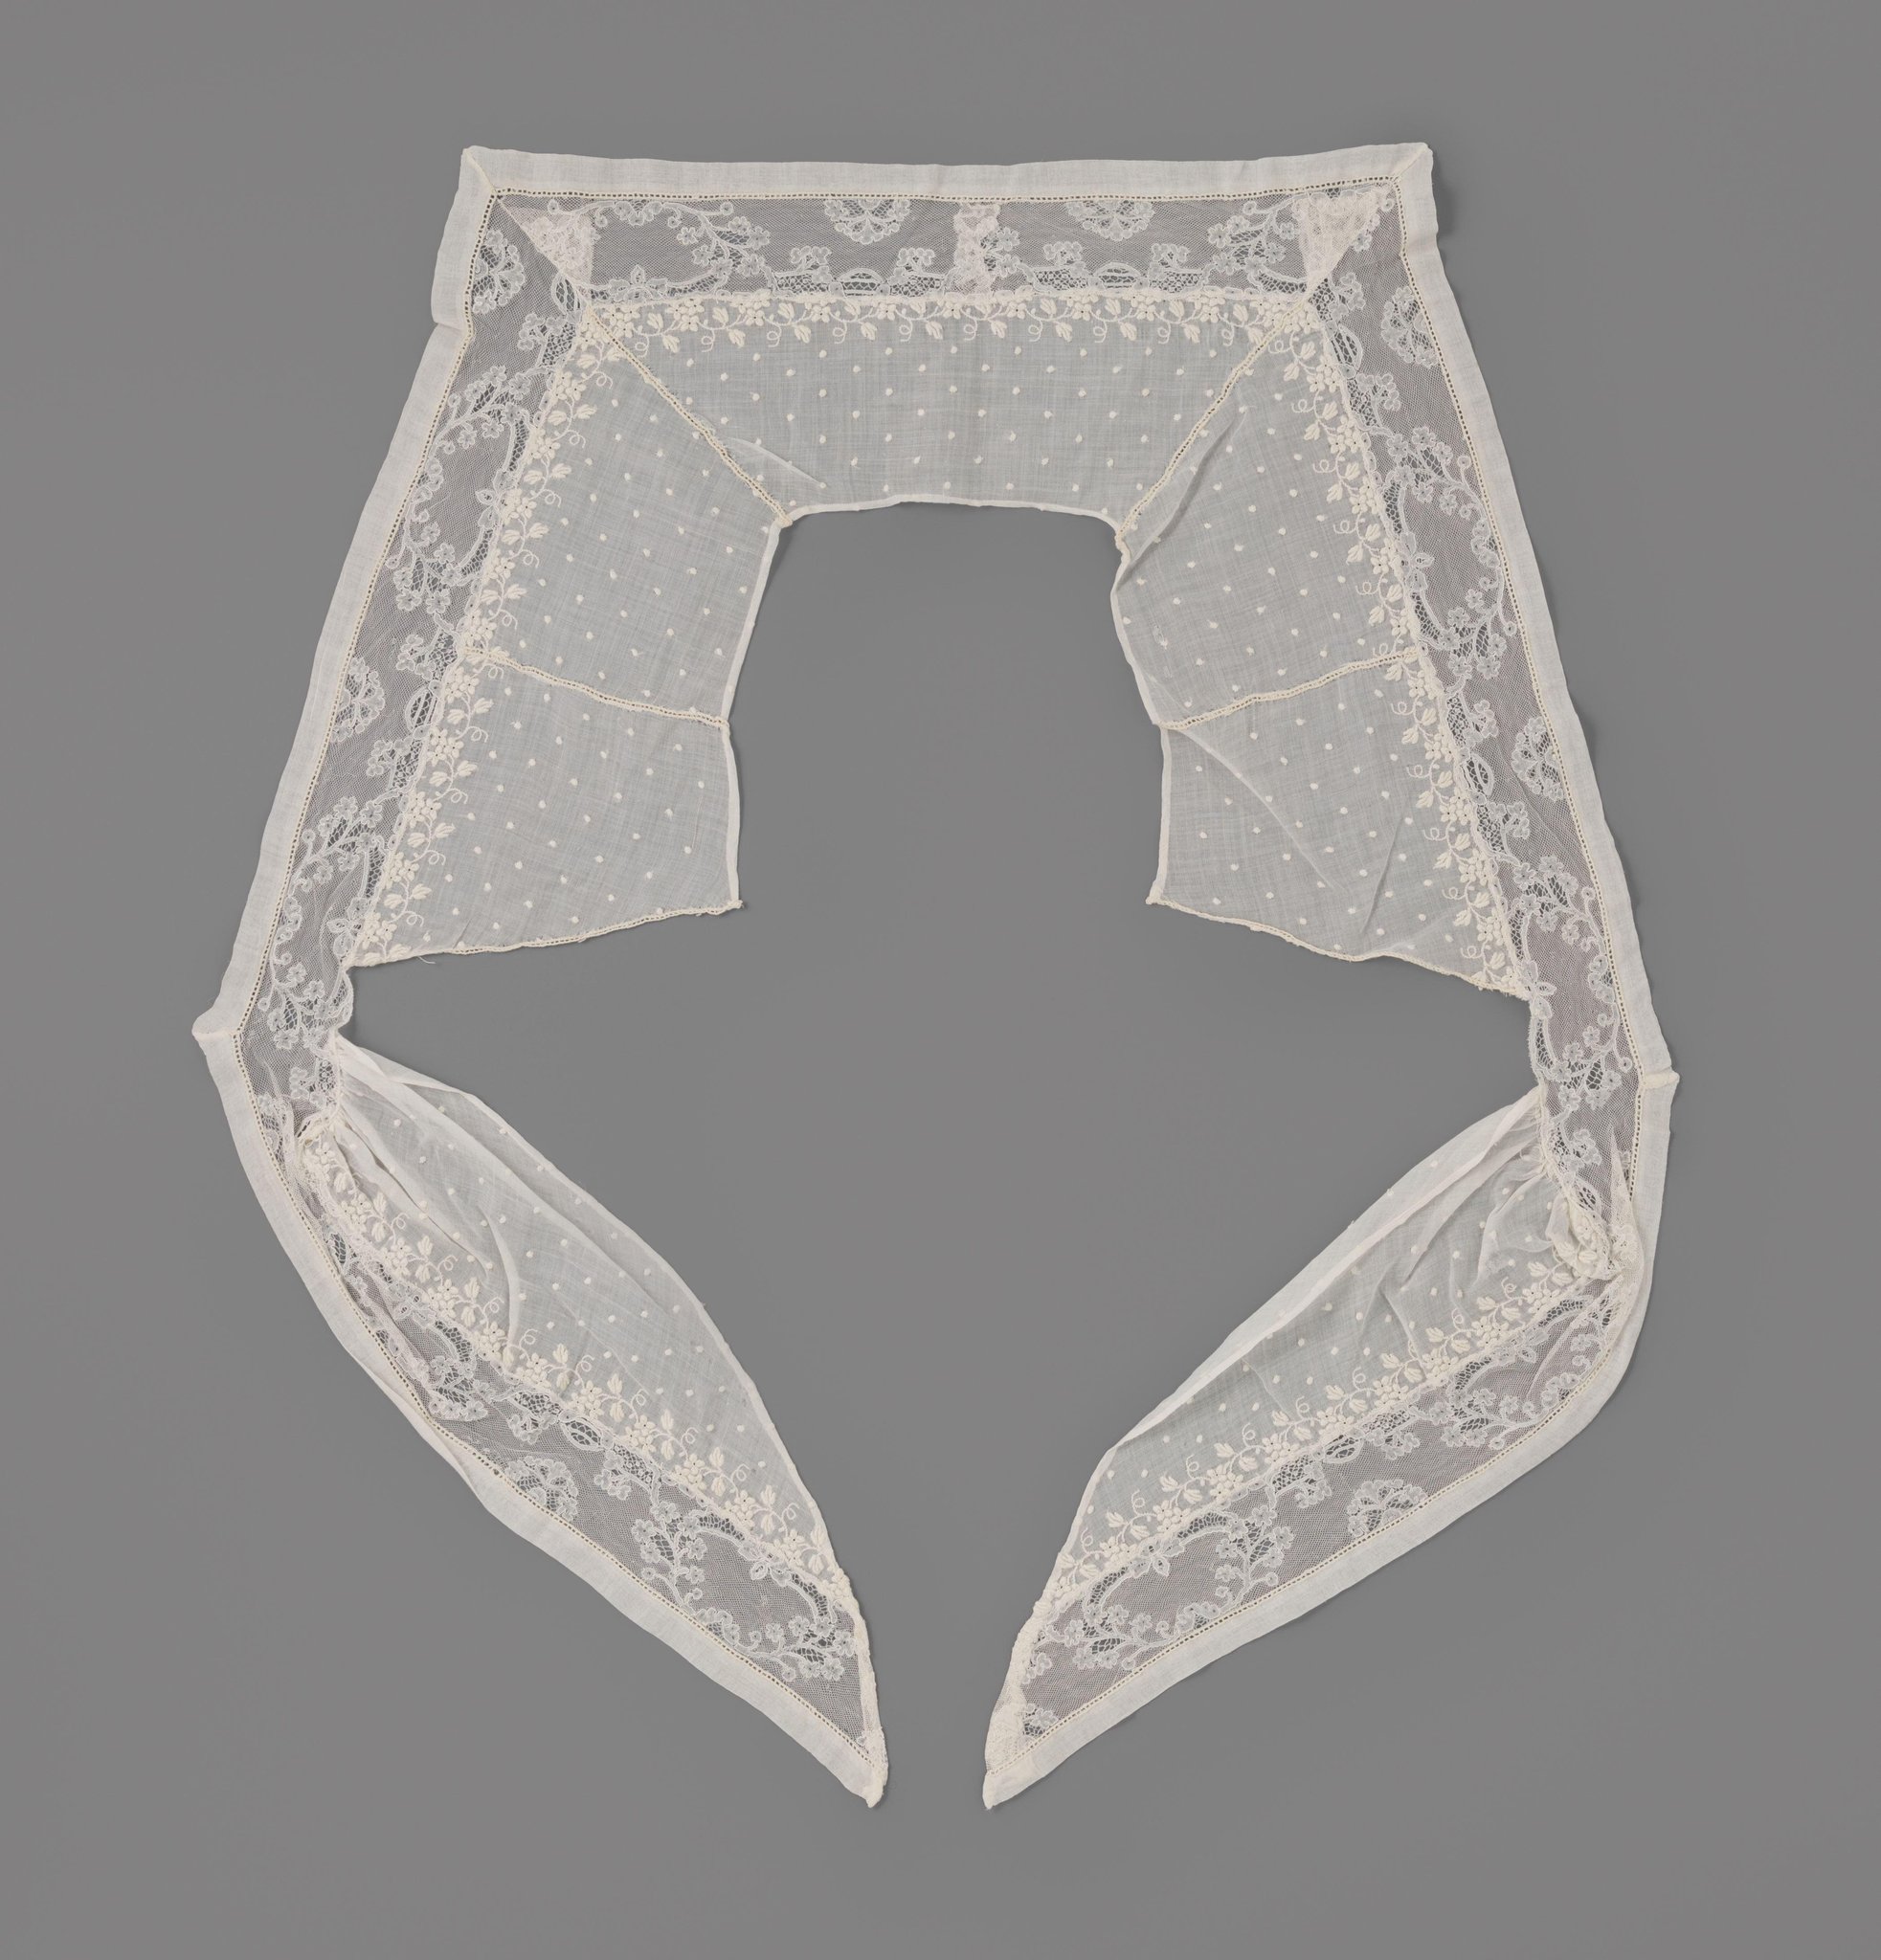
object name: collar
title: Kraag, vierkant, met lange slippen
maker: Anonymous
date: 1760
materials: linen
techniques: embroidery, lace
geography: mechelen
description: Kraag, vierkant, met lange slippen van machinaal geborduurd linnenbatist gedecoreerd met bloemranken langs de onderrand en moesjes daarboven, afgezet met een strook Mechelse kant met bloemranken voorzien van een verdikte contourdraad.